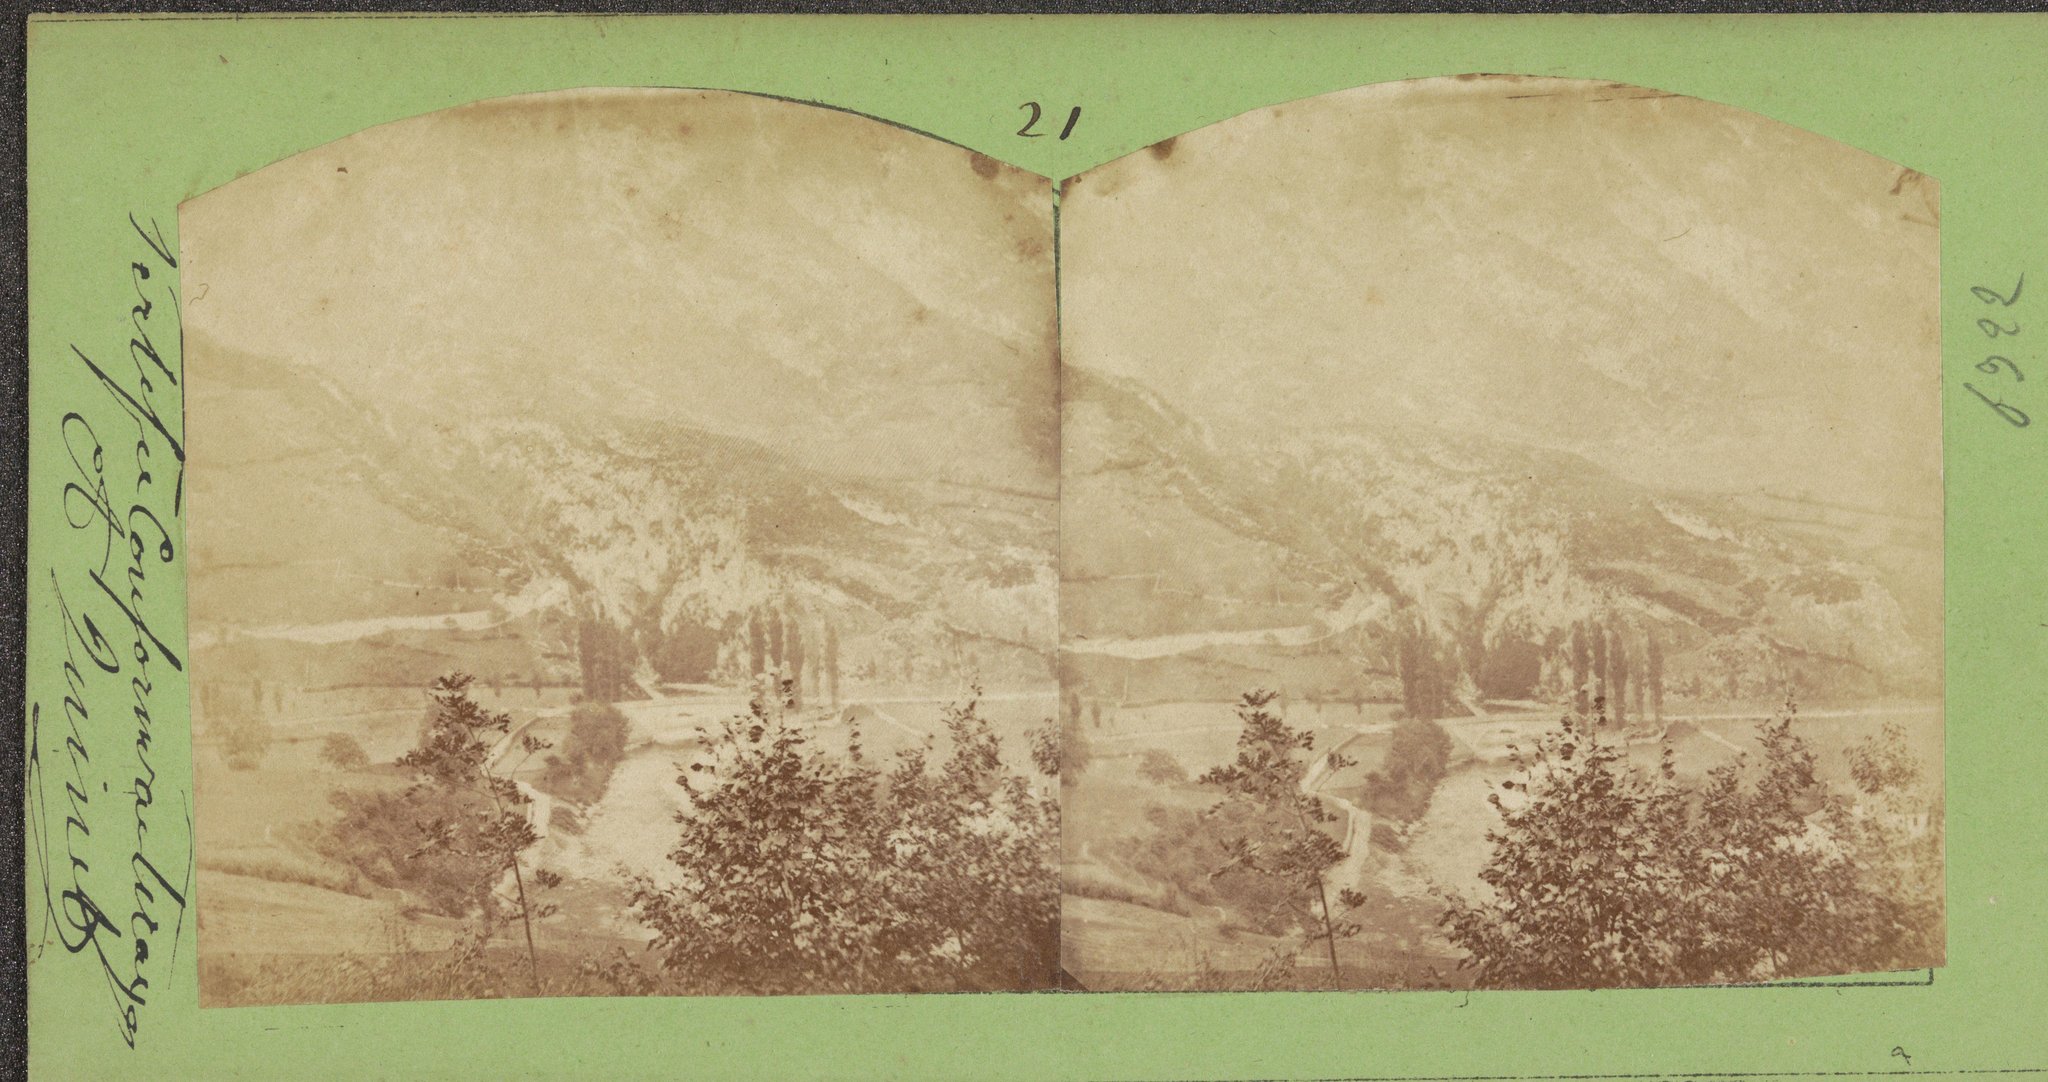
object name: stereograph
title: Bosschage met voet van de Alpen op de achtergrond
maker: achille quinet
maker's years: 1831-1900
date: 1860-1880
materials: cardboard, paper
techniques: albumen print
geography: alps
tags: mountains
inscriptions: signature: ‘Sertifier conforme au tirages // A Quinet’